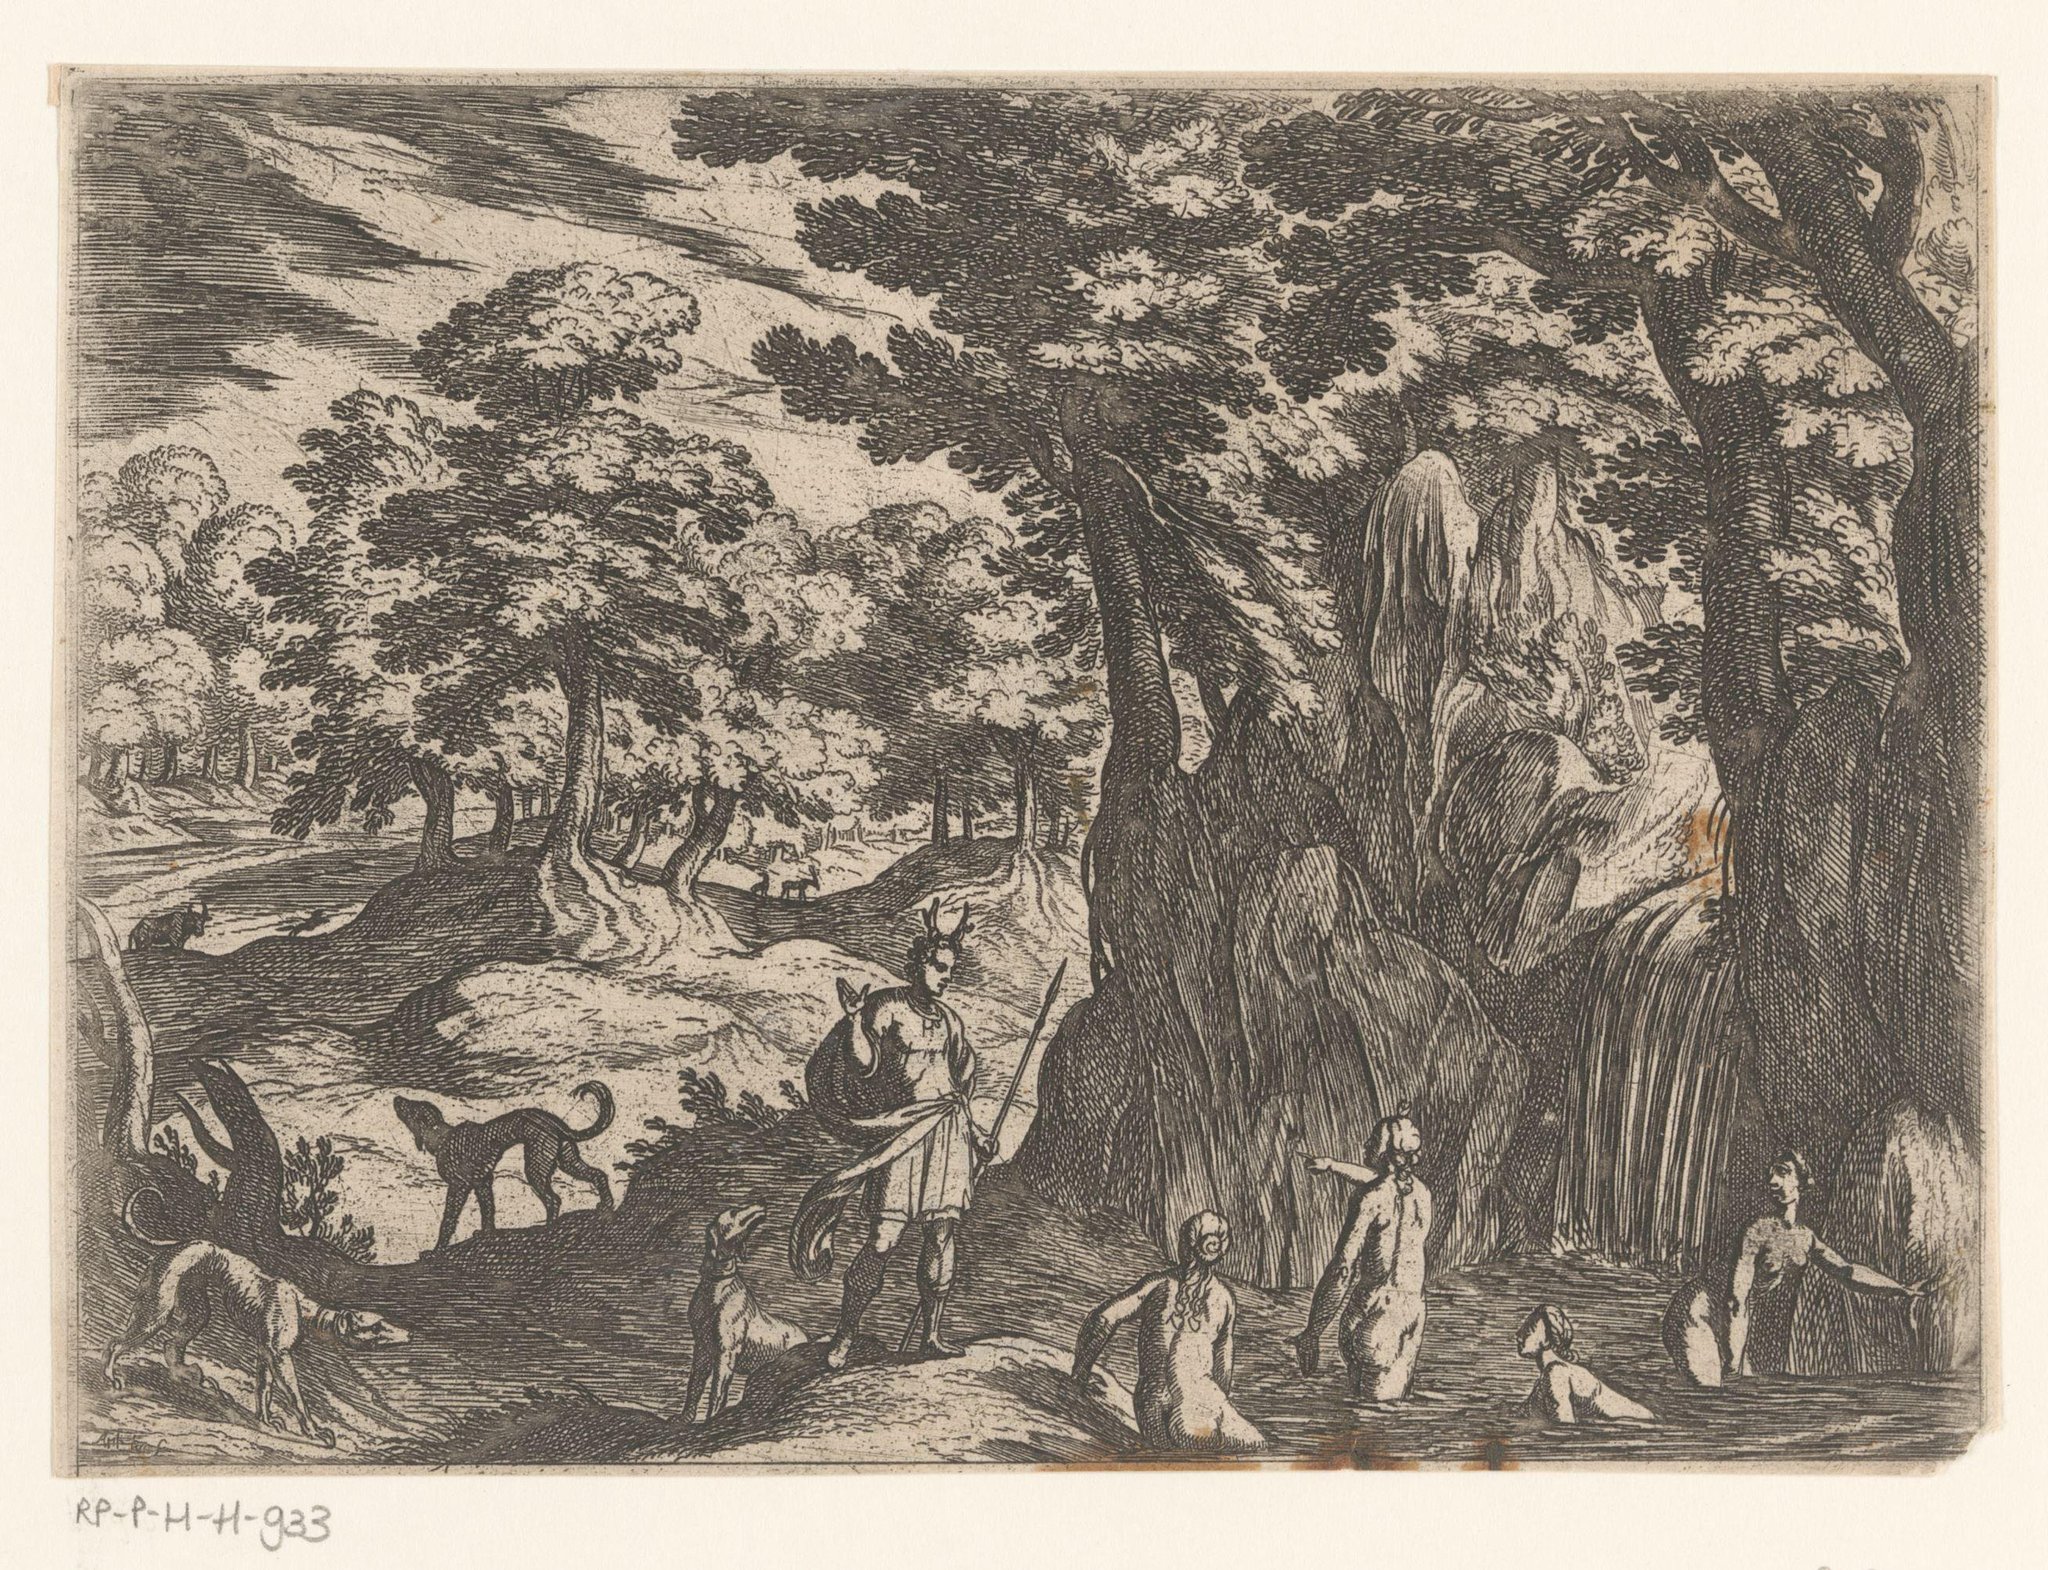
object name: print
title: Landschappen met mythologische scènes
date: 1565-1630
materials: paper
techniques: etching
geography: italy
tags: hoofed animals: deer, landscapes - hh - ideal landscapes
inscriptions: collector's mark: ‘Hinloopen’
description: Boslandschap met Diana en haar nimfen die baden in een waterpoel. Actaeon stond de nimfen te begluren en wordt voor straf in een hert veranderd. Actaeon krijgt een gewei.